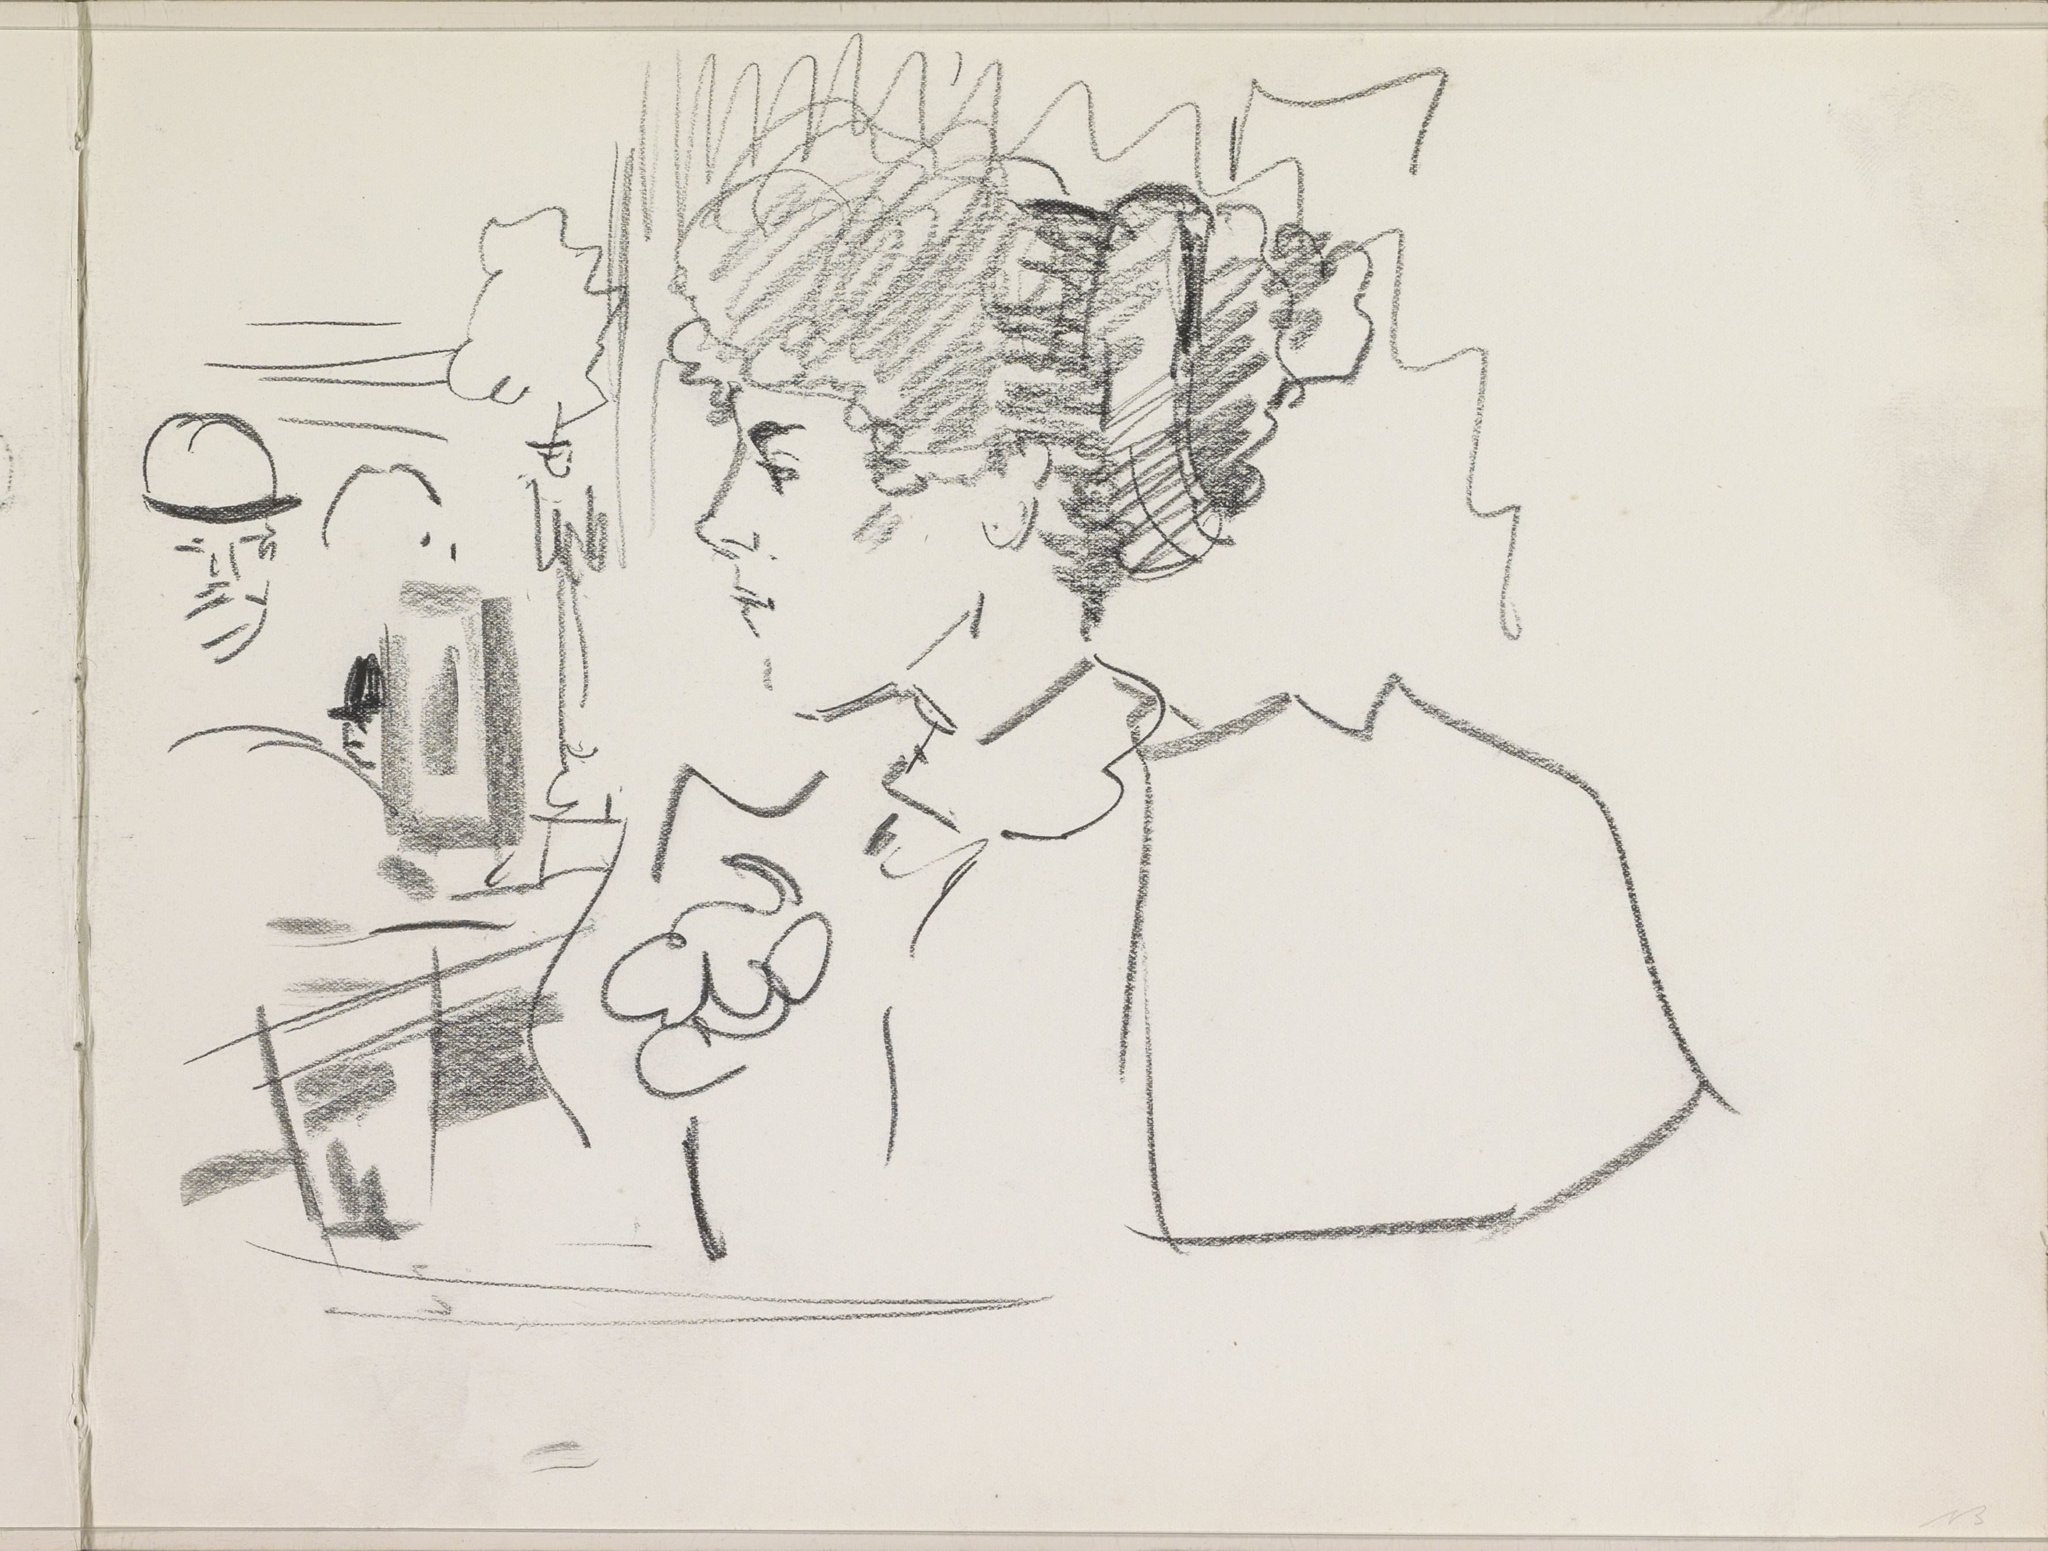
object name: sketchbook leaf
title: Vrouw, mogelijk in een etablissement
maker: isaac israels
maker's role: draughtsman, painter, print maker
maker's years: 1865-1934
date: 1875-1934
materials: chalk, paper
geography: the hague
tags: adult woman, adult man, inn, coffee-house, public house, etc.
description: Mogelijk een serveerster. Voor haar staat een glas. Op de achtergrond mannen. Blad 13 recto uit schetsboek VII met 26 bladen.